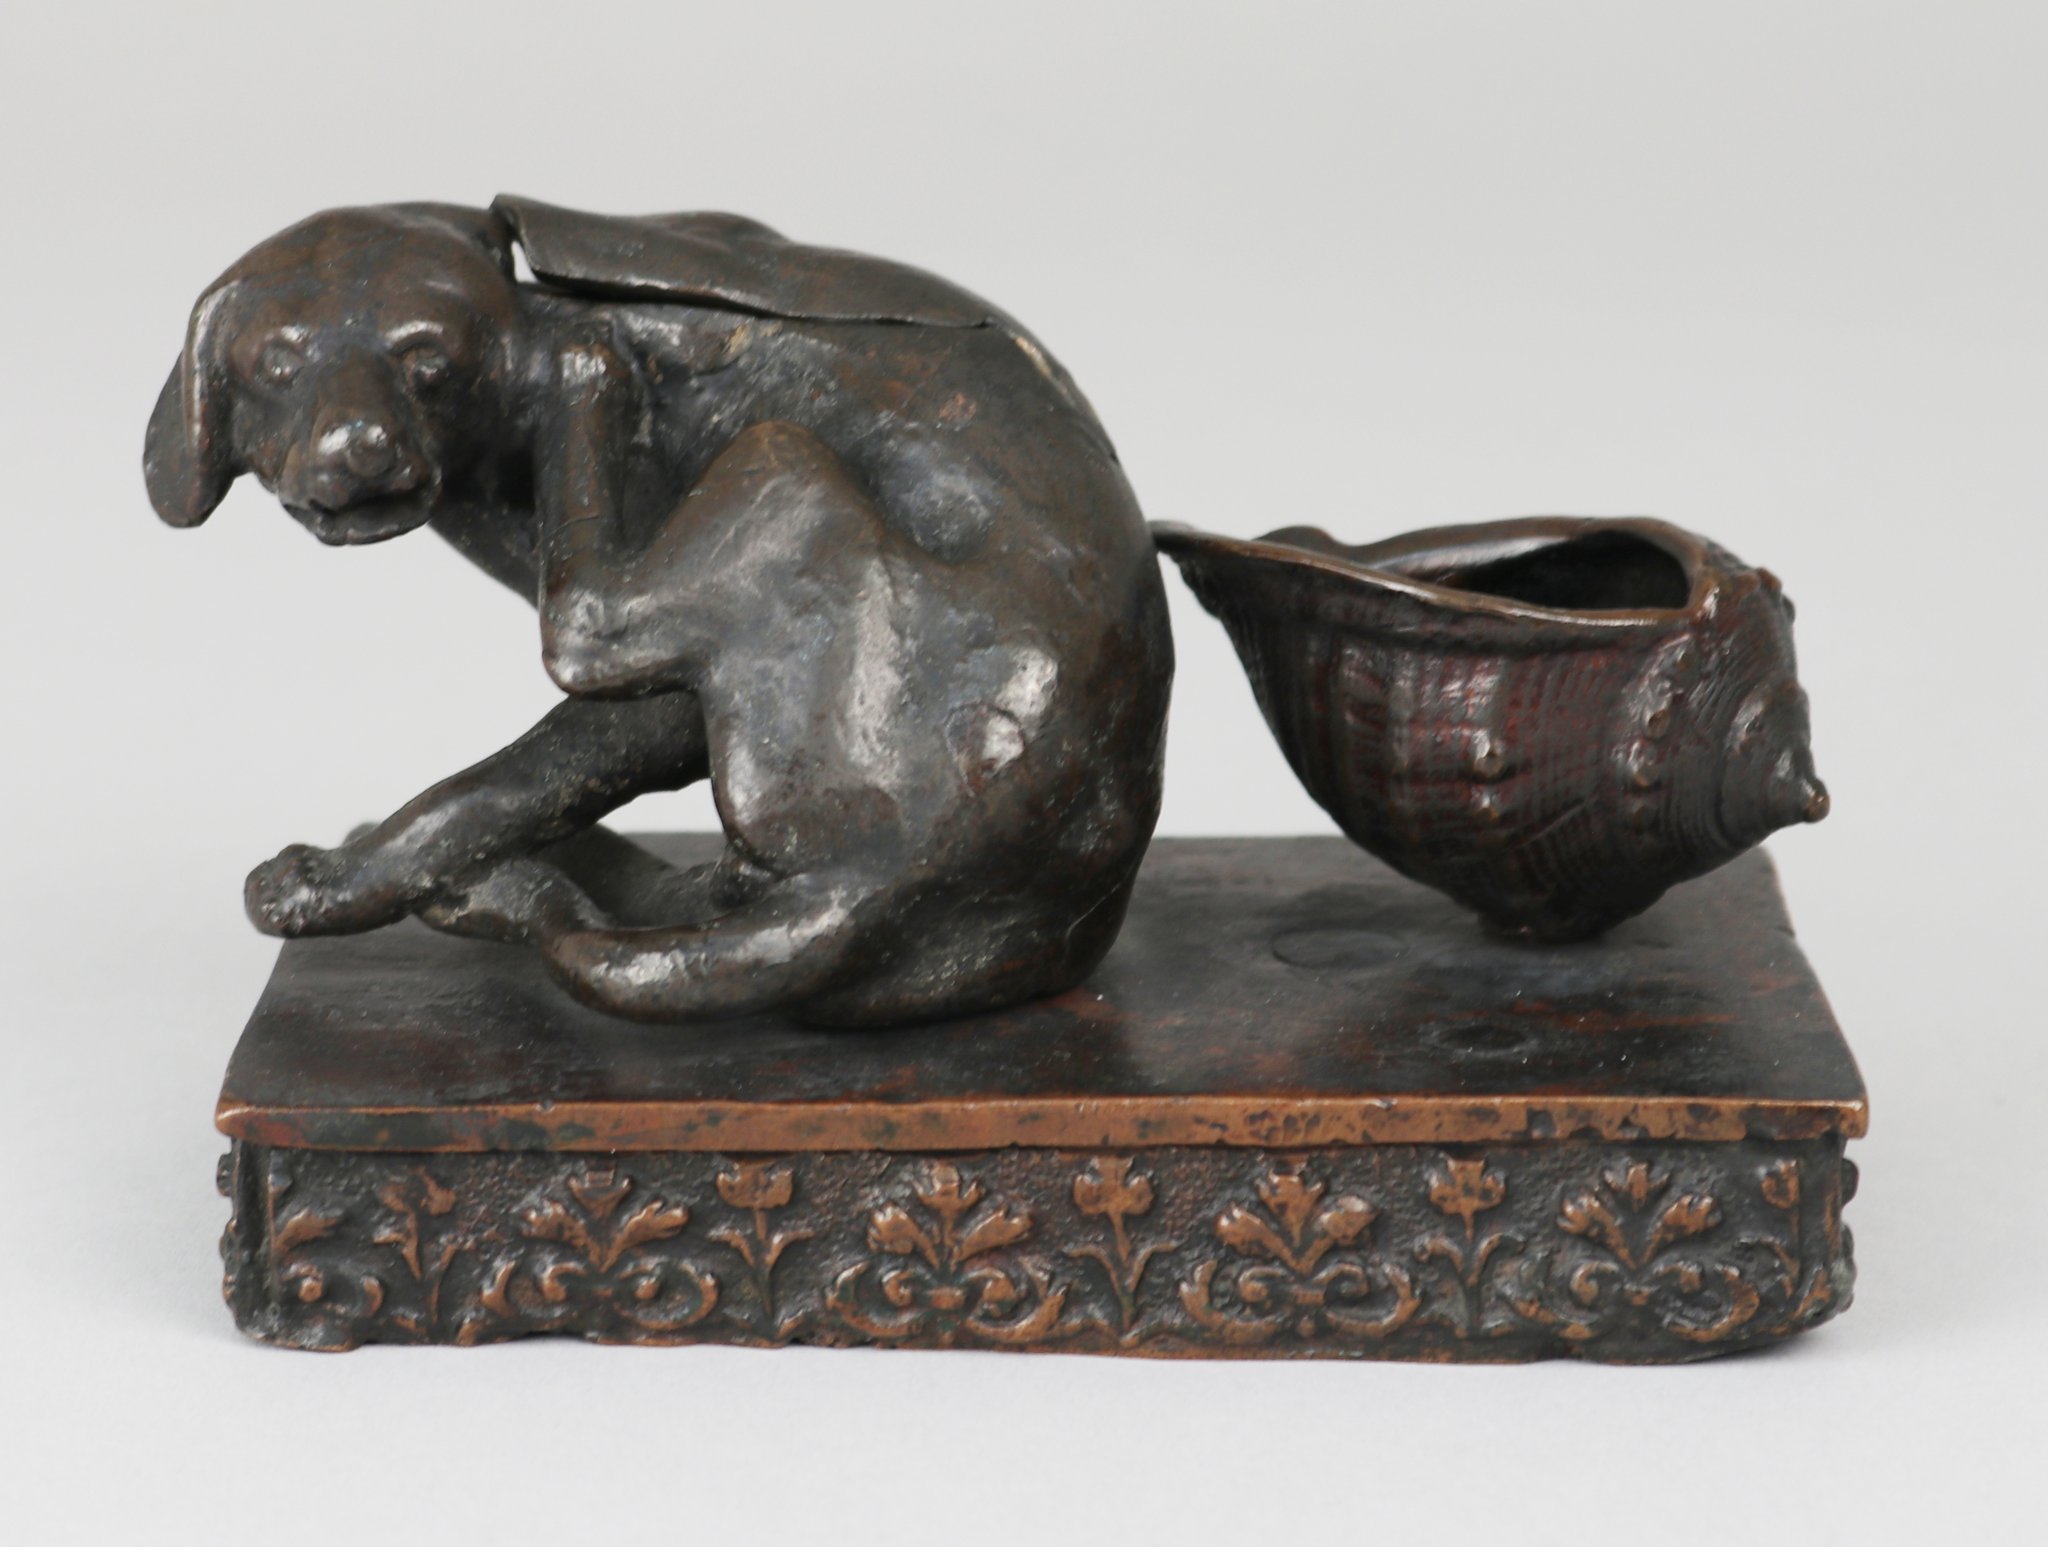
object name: inkstand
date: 1530-1550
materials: bronze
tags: dogs,shells